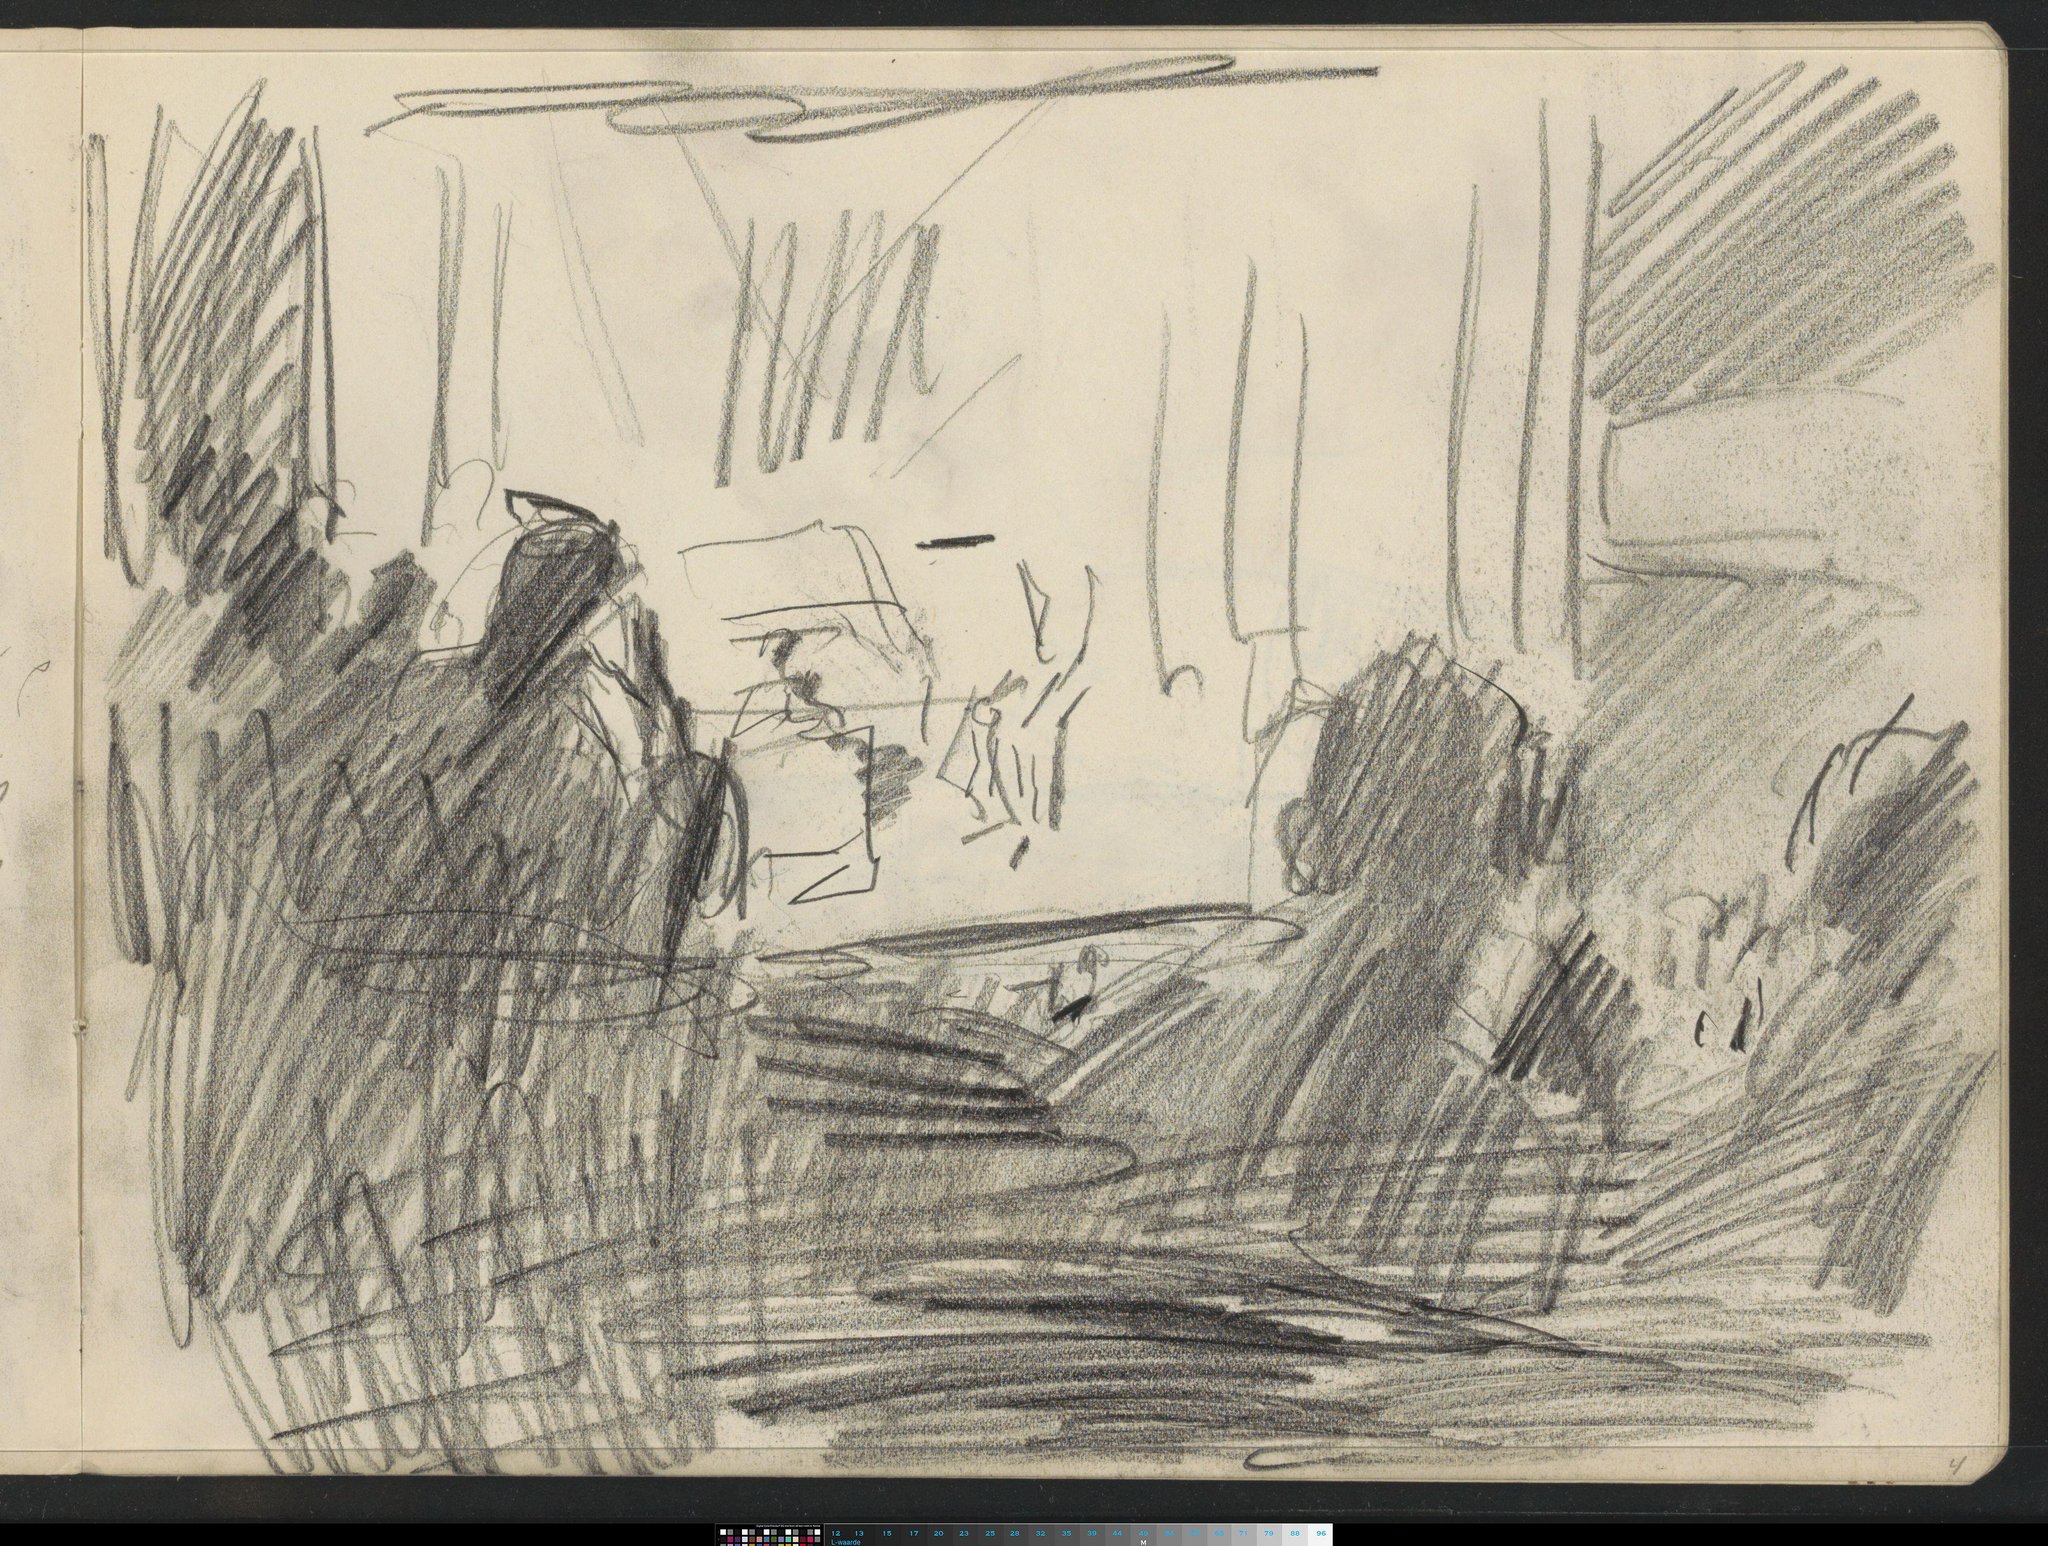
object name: sketchbook leaf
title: Toeschouwers bij een theatervoorstelling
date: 1915-1934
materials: paper, pencil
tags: acrobat ~ circus, the audience ~ art performance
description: Op de achtergrond figuren op het podium. Blad 4 recto uit schetsboek XVI met 32 bladen.